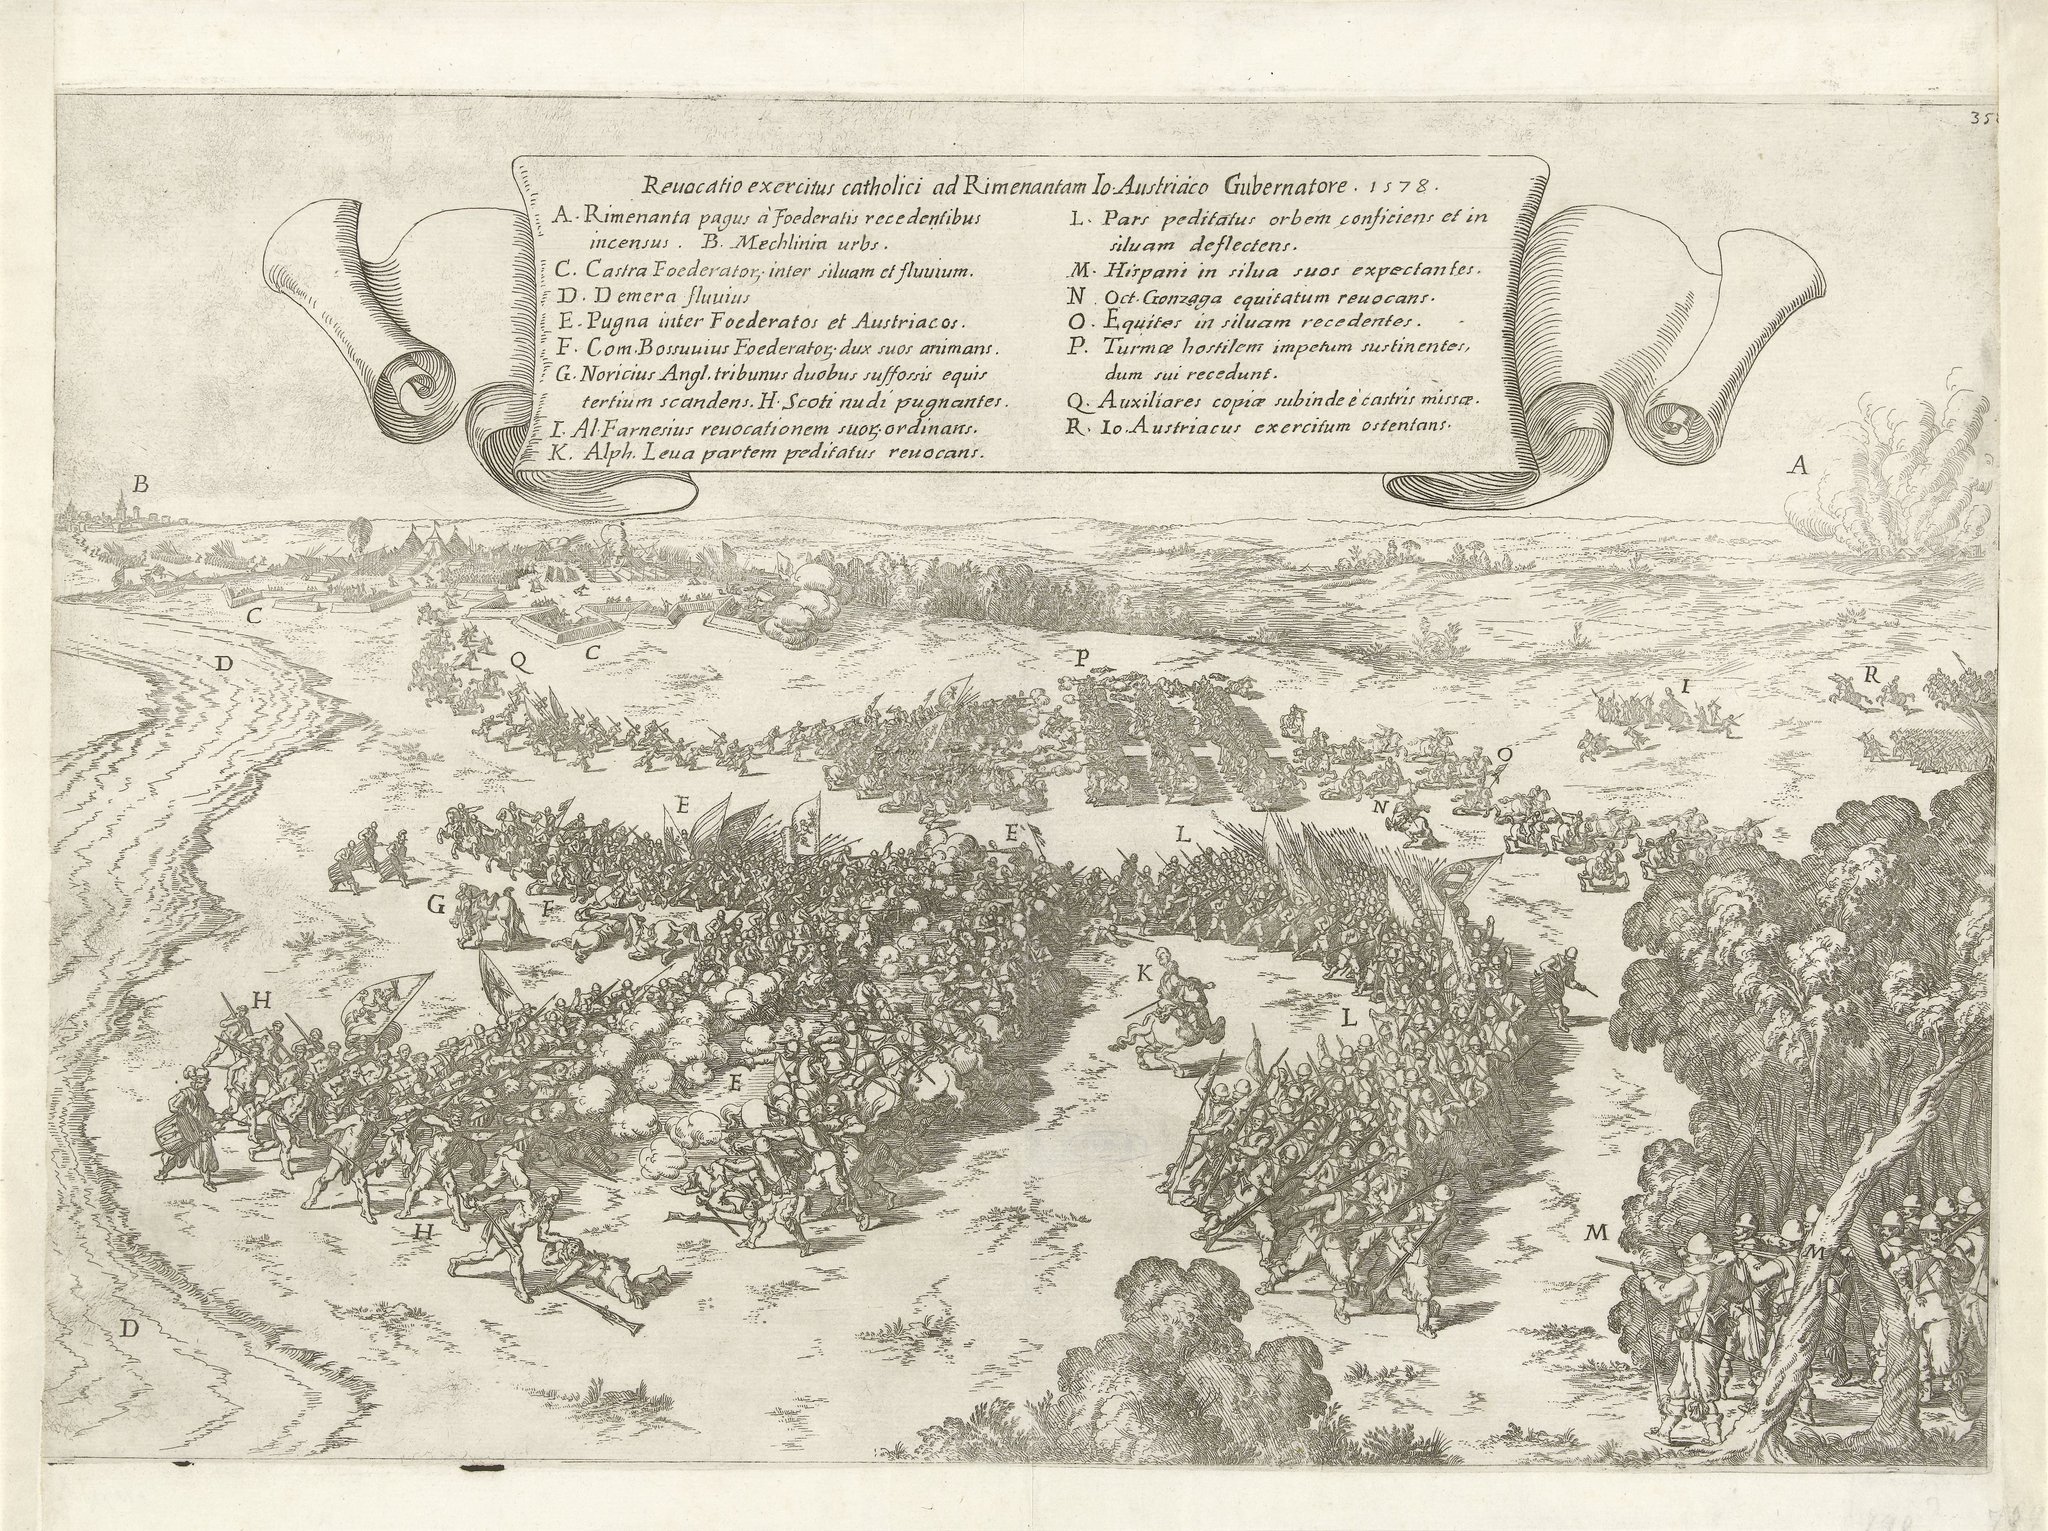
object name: history print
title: Veldslag bij Rijmenam, 1578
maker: johann wilhelm baur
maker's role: draughtsman, painter, print maker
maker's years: 1607-1642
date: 1630-1632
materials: paper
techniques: etching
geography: rome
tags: battle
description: Veldslag bij Rijmenam tussen het Staatse leger onder Bossu en de troepen van Don Juan en Parma, 1 augustus 1578. Op de voorgrond de veldslag, links in de verte de Mechelen. Bovin een banderol met titel en legenda A-R in het Latijn.